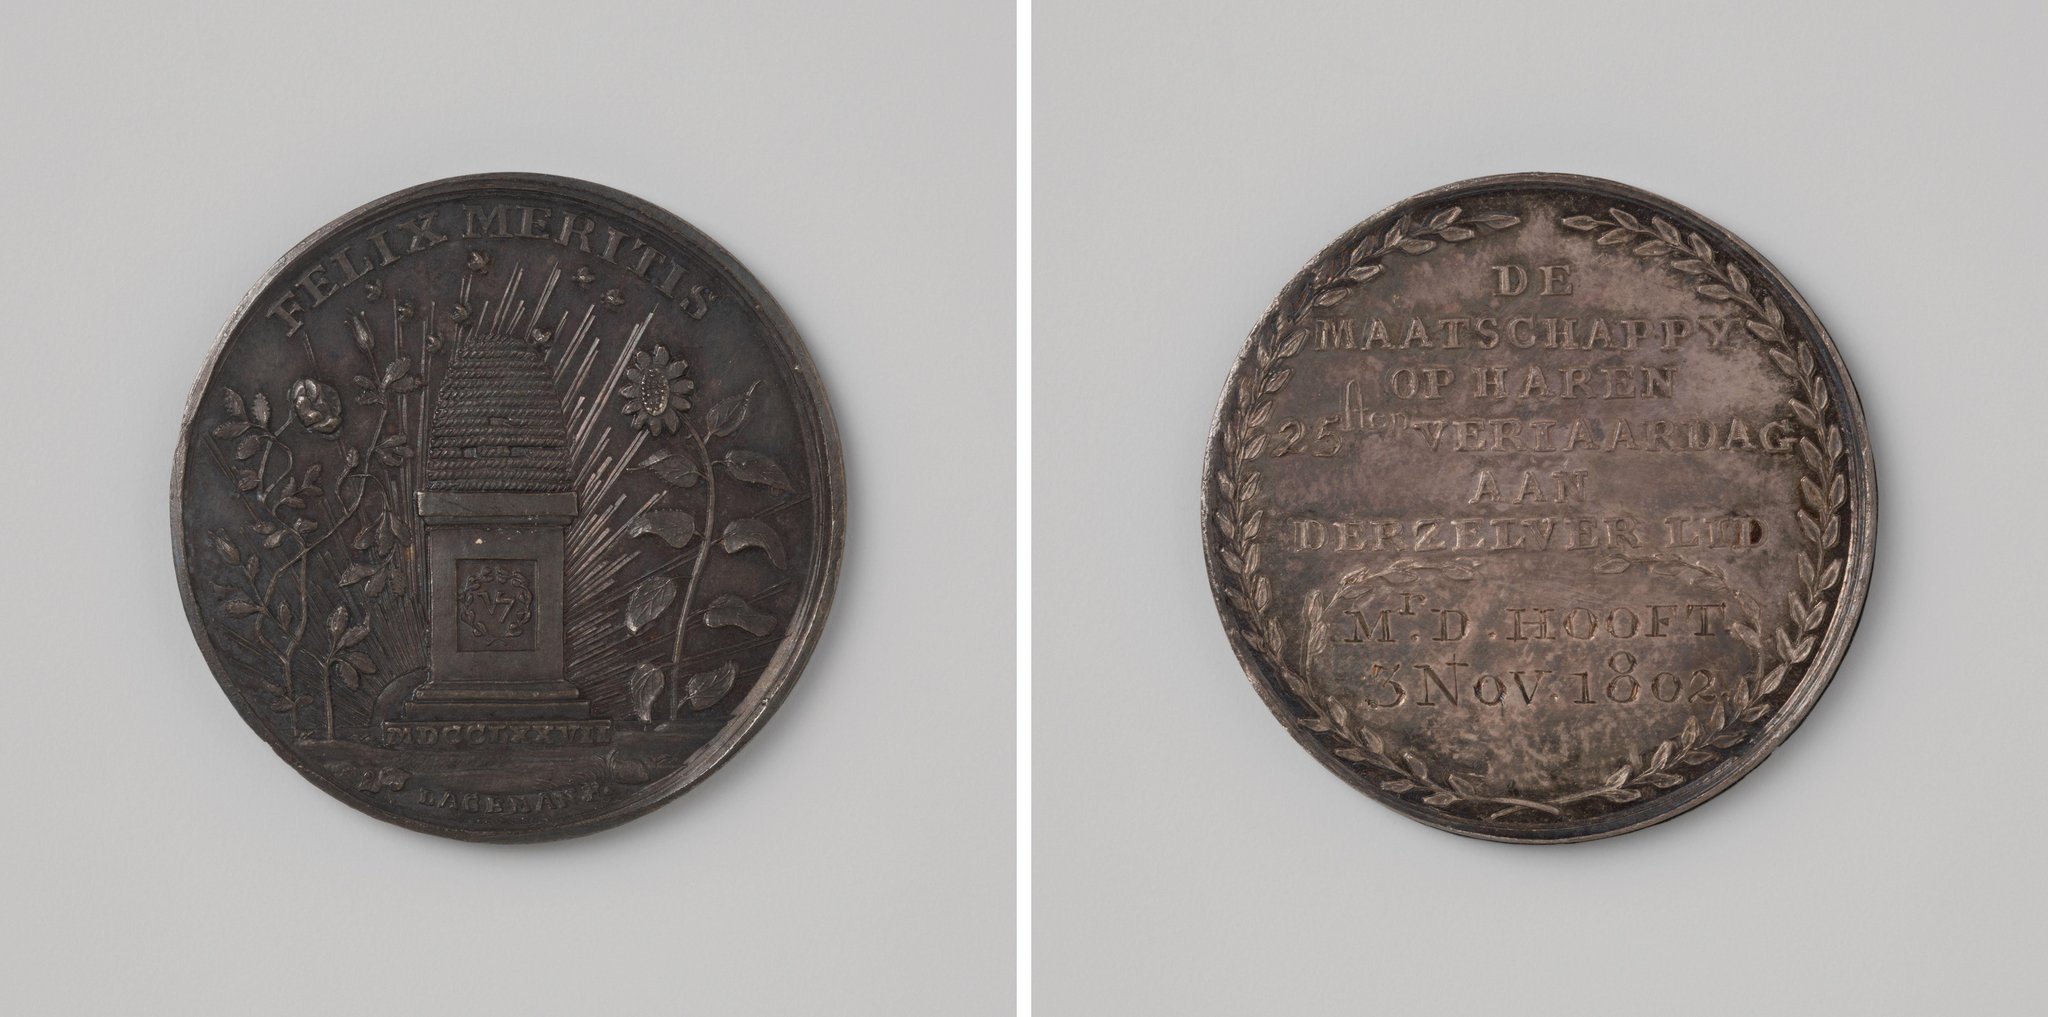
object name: honorary medal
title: Vijfentwintigjarig bestaan van het genootschap "Felix Meritis", penning uitgereikt aan mr. D. Hooft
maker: johannes michiel lageman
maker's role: silversmith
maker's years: 1735-1809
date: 1802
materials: silver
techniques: engraving, striking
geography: amsterdam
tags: amsterdam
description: Zilveren penning. Voorzijde: bijenkorf, staande op altaar tussen rozestruik en zonnebloem, beschenen door opgaande zon binnen omschrift; afsnede: signatuur. Keerzijde: opschrift binnen bladerkrans